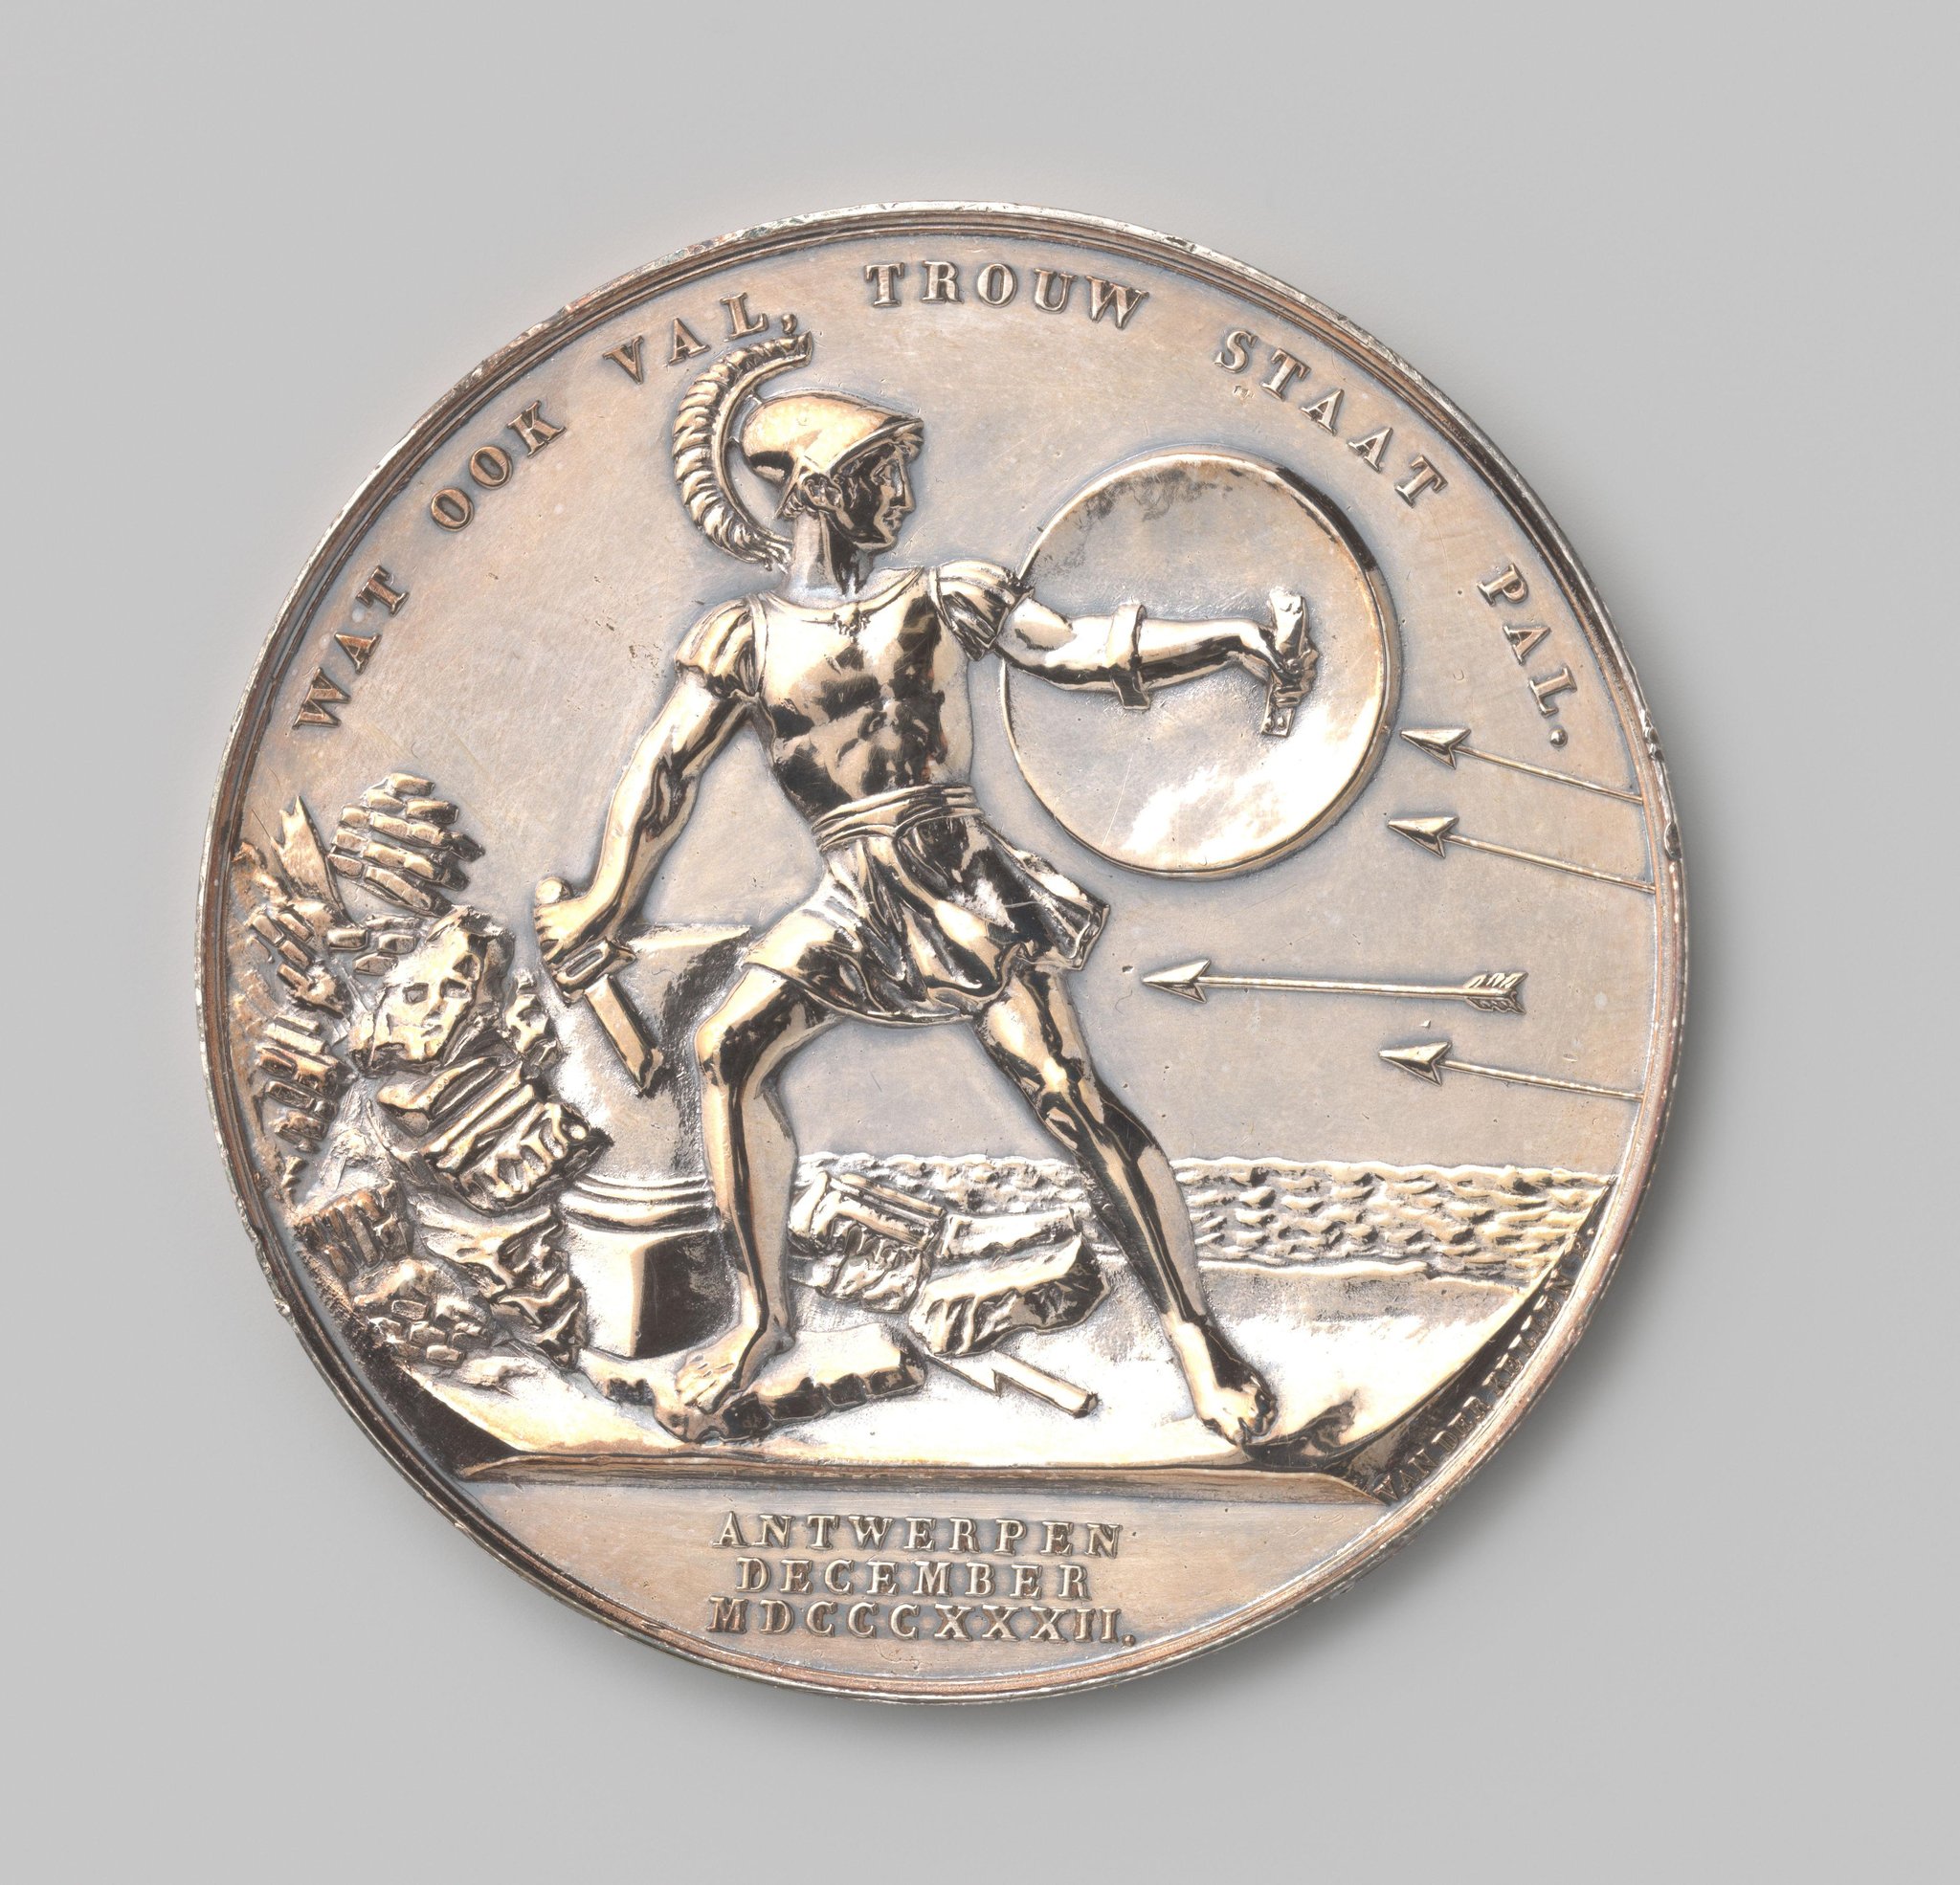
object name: medal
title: Zilveren herinneringsmedaille van kapitein G. Leers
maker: Anonymous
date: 1832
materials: silver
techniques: forging, striking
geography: netherlands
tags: strijd om de citadel van antwerpen (1832)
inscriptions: date: ‘ANTWERPEN DECEMBER MDCCCXXXII’, : ‘WAT OOK VAL. TROUW STAAT PAL.’, name: ‘G. LEERS KAPITEIN’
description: Zilveren herinneringsmedaille waar een Grieks strijder aan zijn linkerarm een rond schild beschermend voor zich houdt terwijl rechts op de medaille pijlen op hem afgeschoten worden. In zijn rechterhand houdt hij een kort zwaard vast, Achter hem een afgebroken zuil waar puin naast ligt. Aan de bovenzijde een tekst WAT OOK VAL. TROUW STAAT PAL. Onder de strijder een ANTWERPEN DECEMBER MDCCCXXXII. Aan de andere zijde van de medaille een platte kant waar alleen rondom een lauwerkrans is gegraveerd. In het midden de naam G. Leers Kapitein.